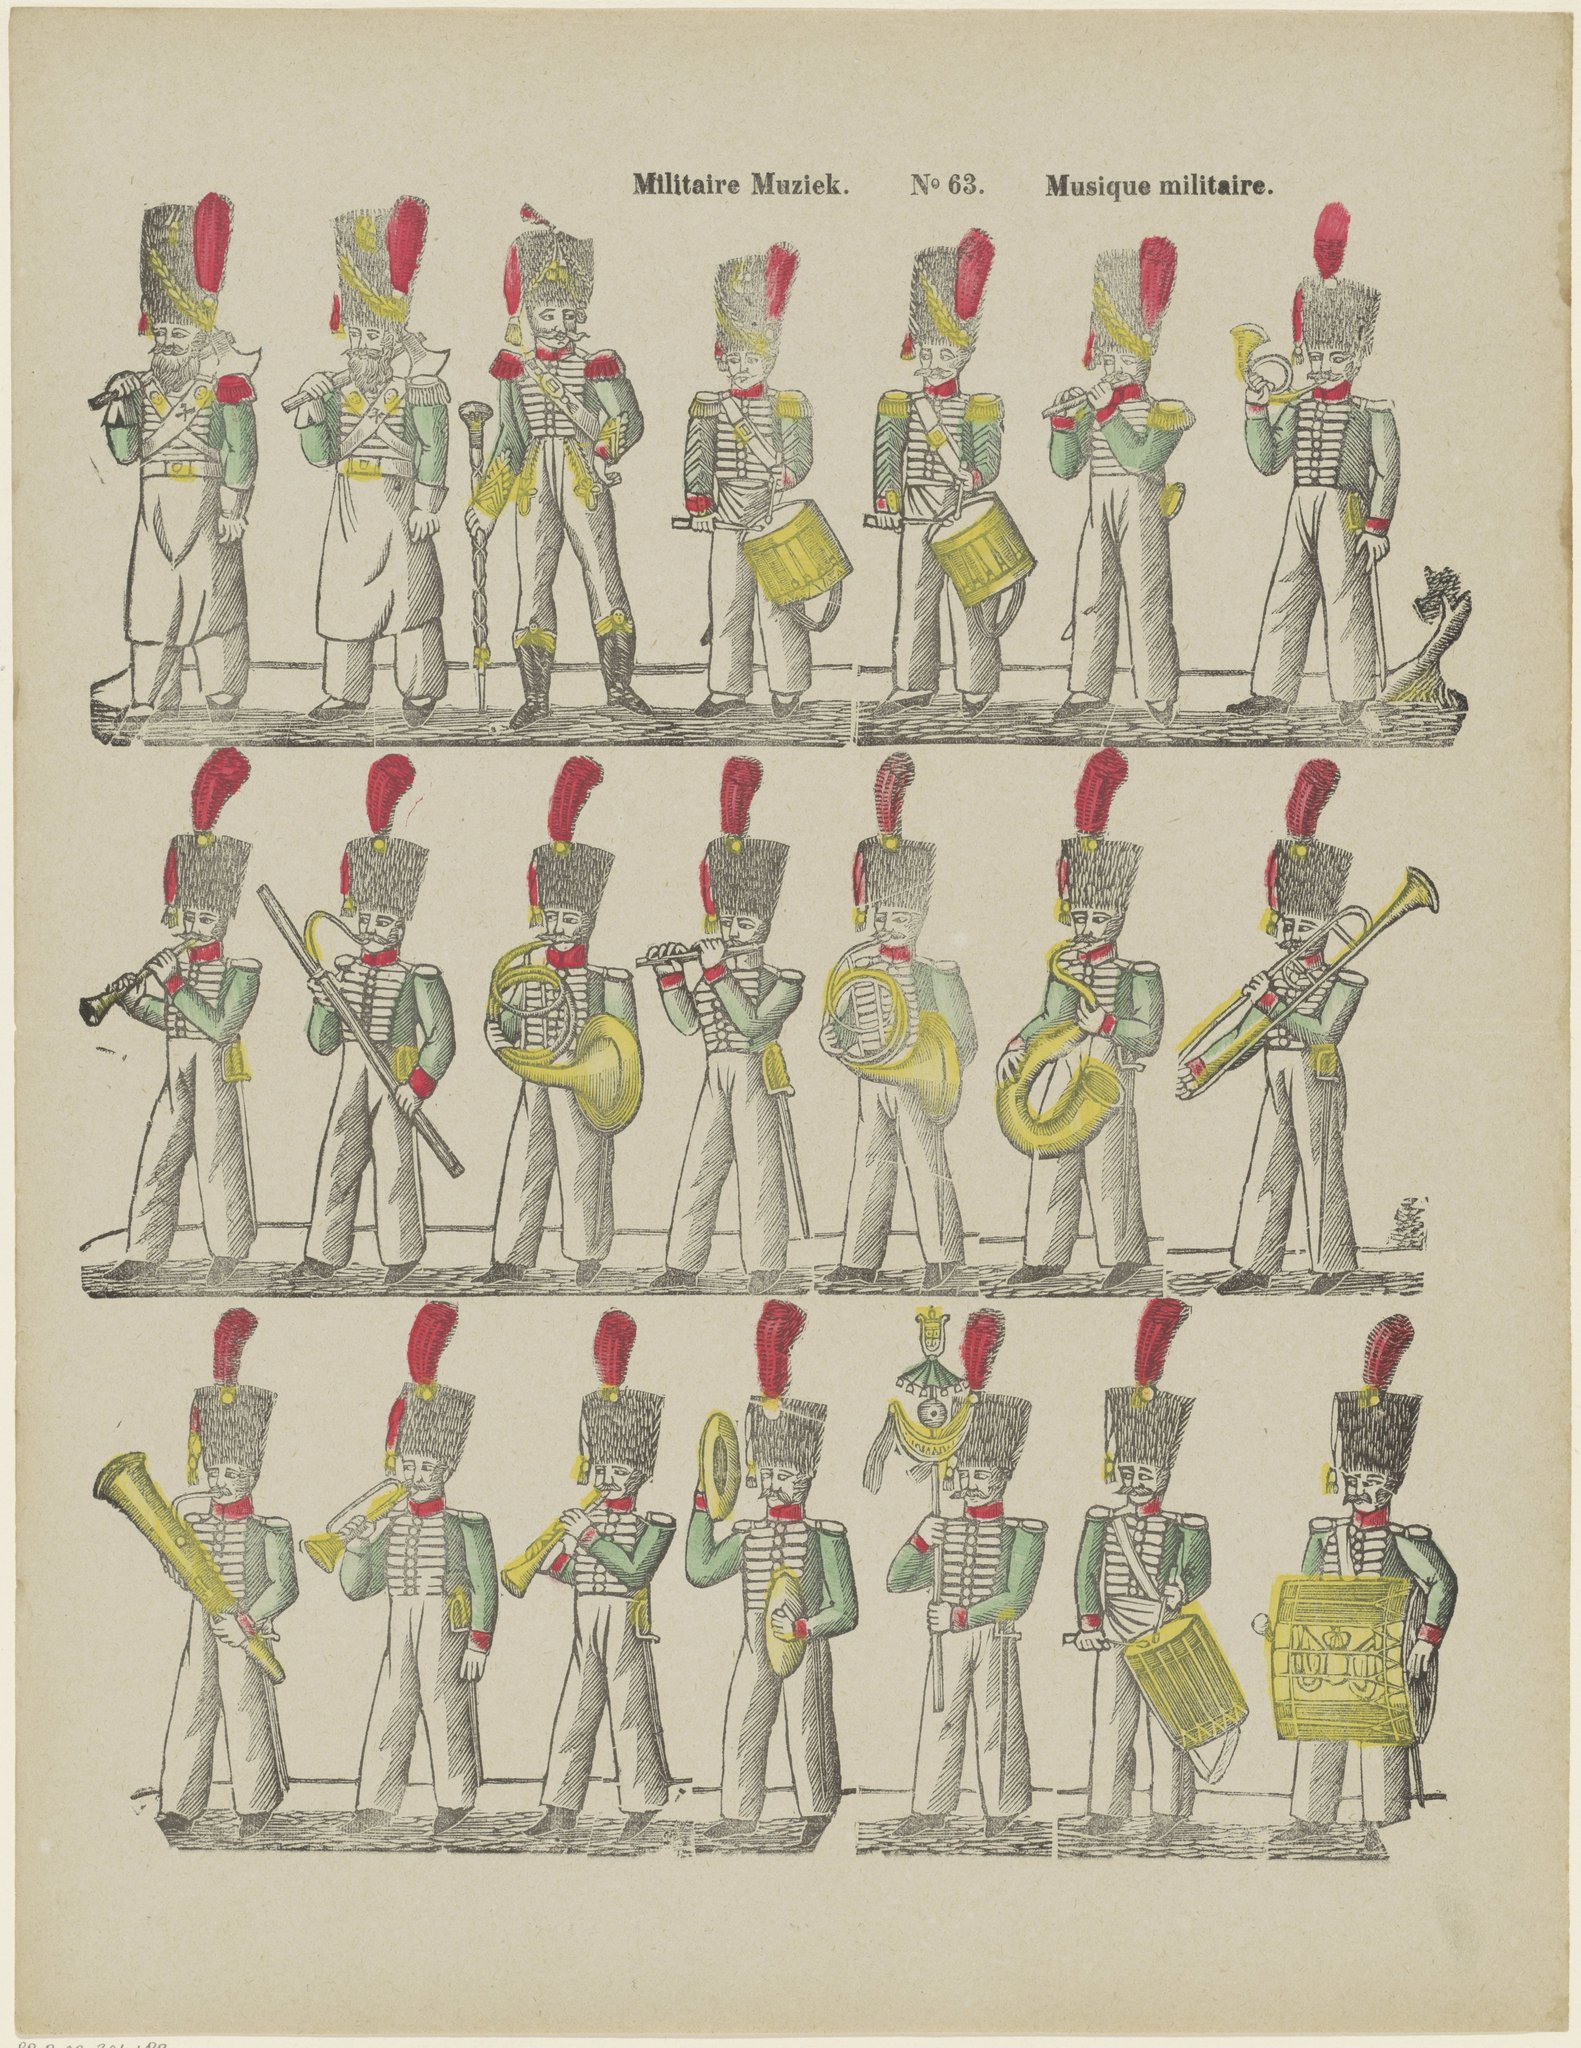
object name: print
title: Militaire muziek / Musique militaire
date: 1866-1902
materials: paper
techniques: colour, letterpress printing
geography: europe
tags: military band, the soldier; the soldier's life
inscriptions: collector's mark: Lugt 2760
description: Blad met drie horizontale rijen met elk 7 voorstellingen van militaire muzikanten. Genummerd midden boven: No 63.